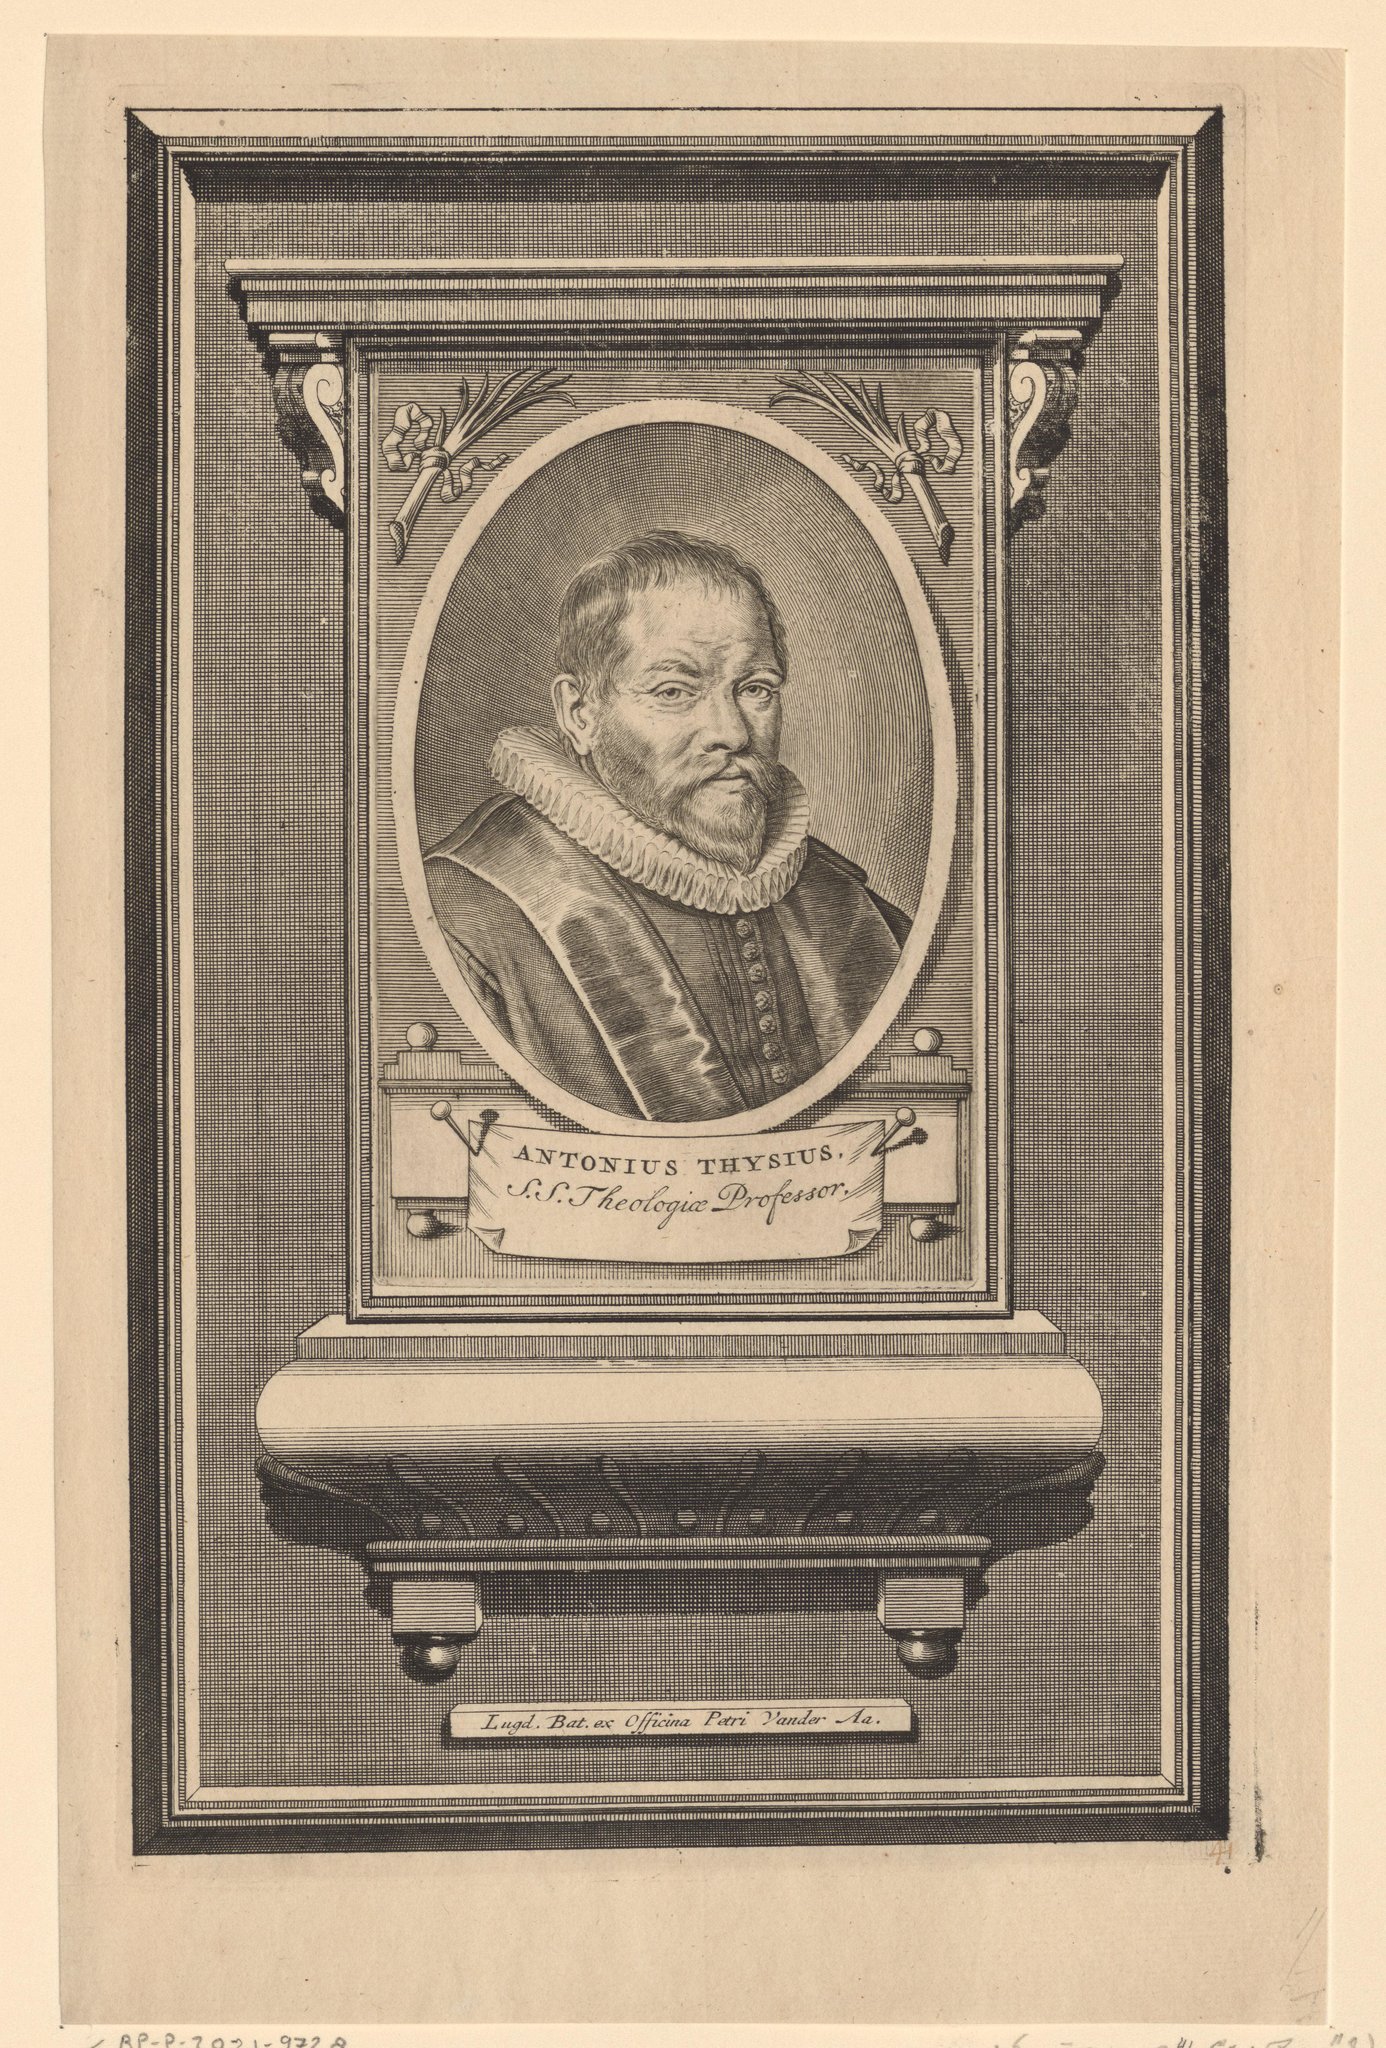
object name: print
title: Fundatoris, curatorum et professorum celeberrimorum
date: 1716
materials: paper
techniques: engraving, etching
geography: leiden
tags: antonius thysius, theologian, historical persons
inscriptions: collector's mark: Lugt 2228, number: ‘41’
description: Eerdere staat gebruikt in: Meursius, Joannes. Athenae Batavae. Sive, de urbe Leidensi & academia, virisuw claris (...). Leiden: Andries Clouck en Bonaventura en Abraham Elzevier, 1625.